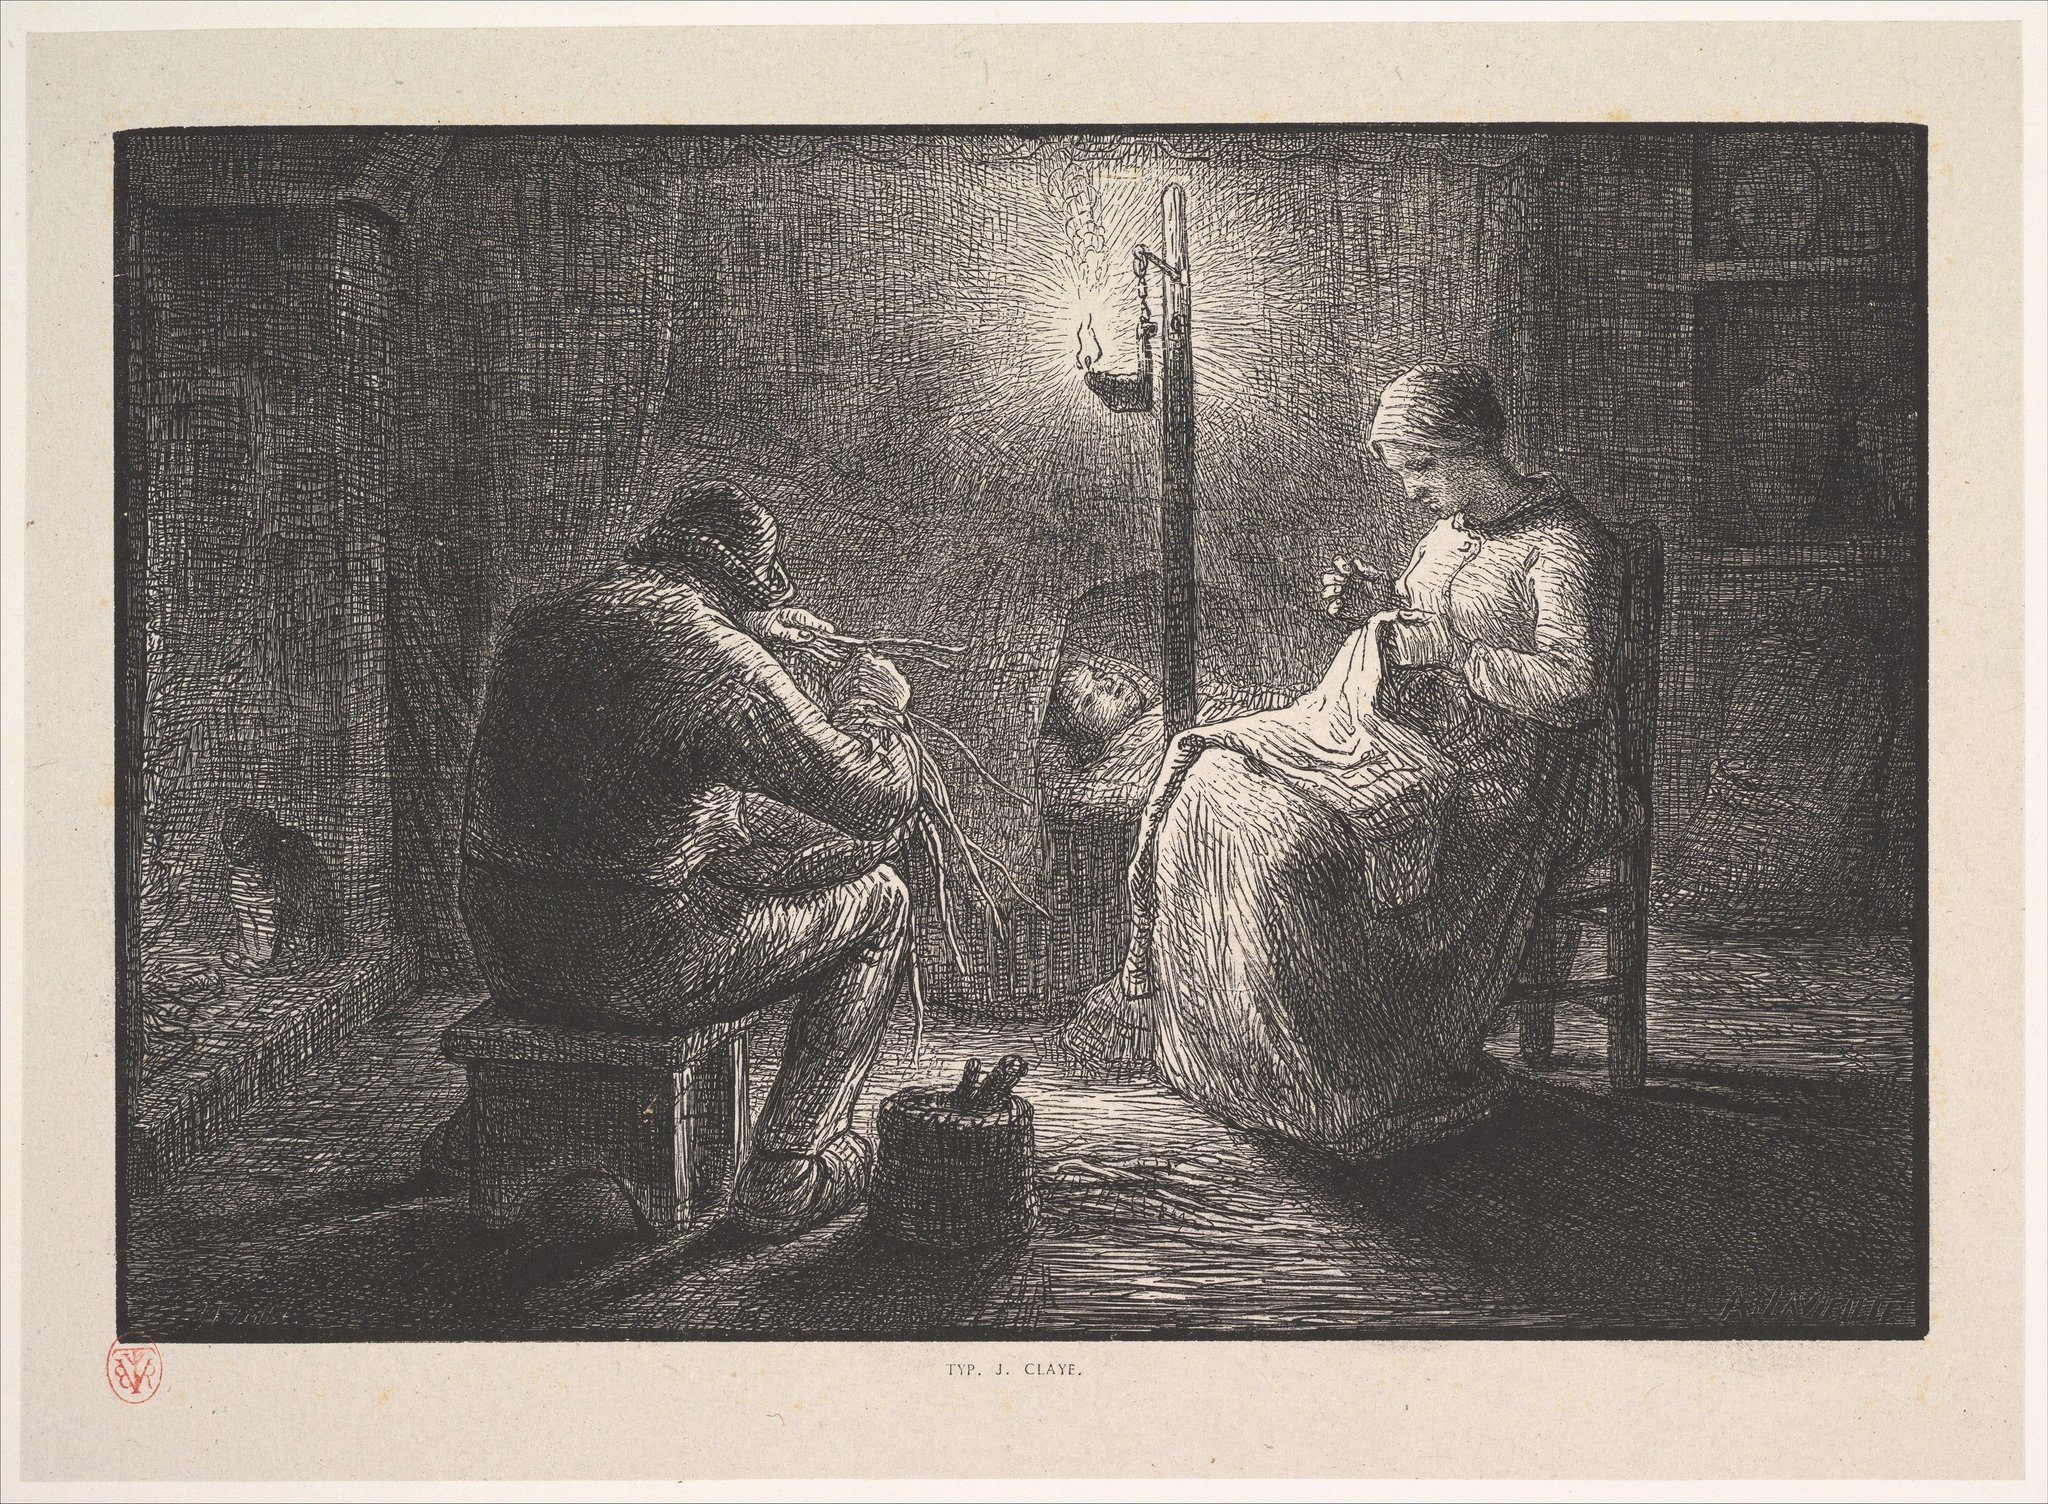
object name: print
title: Night, from "Four Times of the Day"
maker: jean-françois millet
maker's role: artist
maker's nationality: french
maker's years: 1814-1875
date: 1830-1875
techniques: printmaking, engraving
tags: infants,men,women,night,sewing